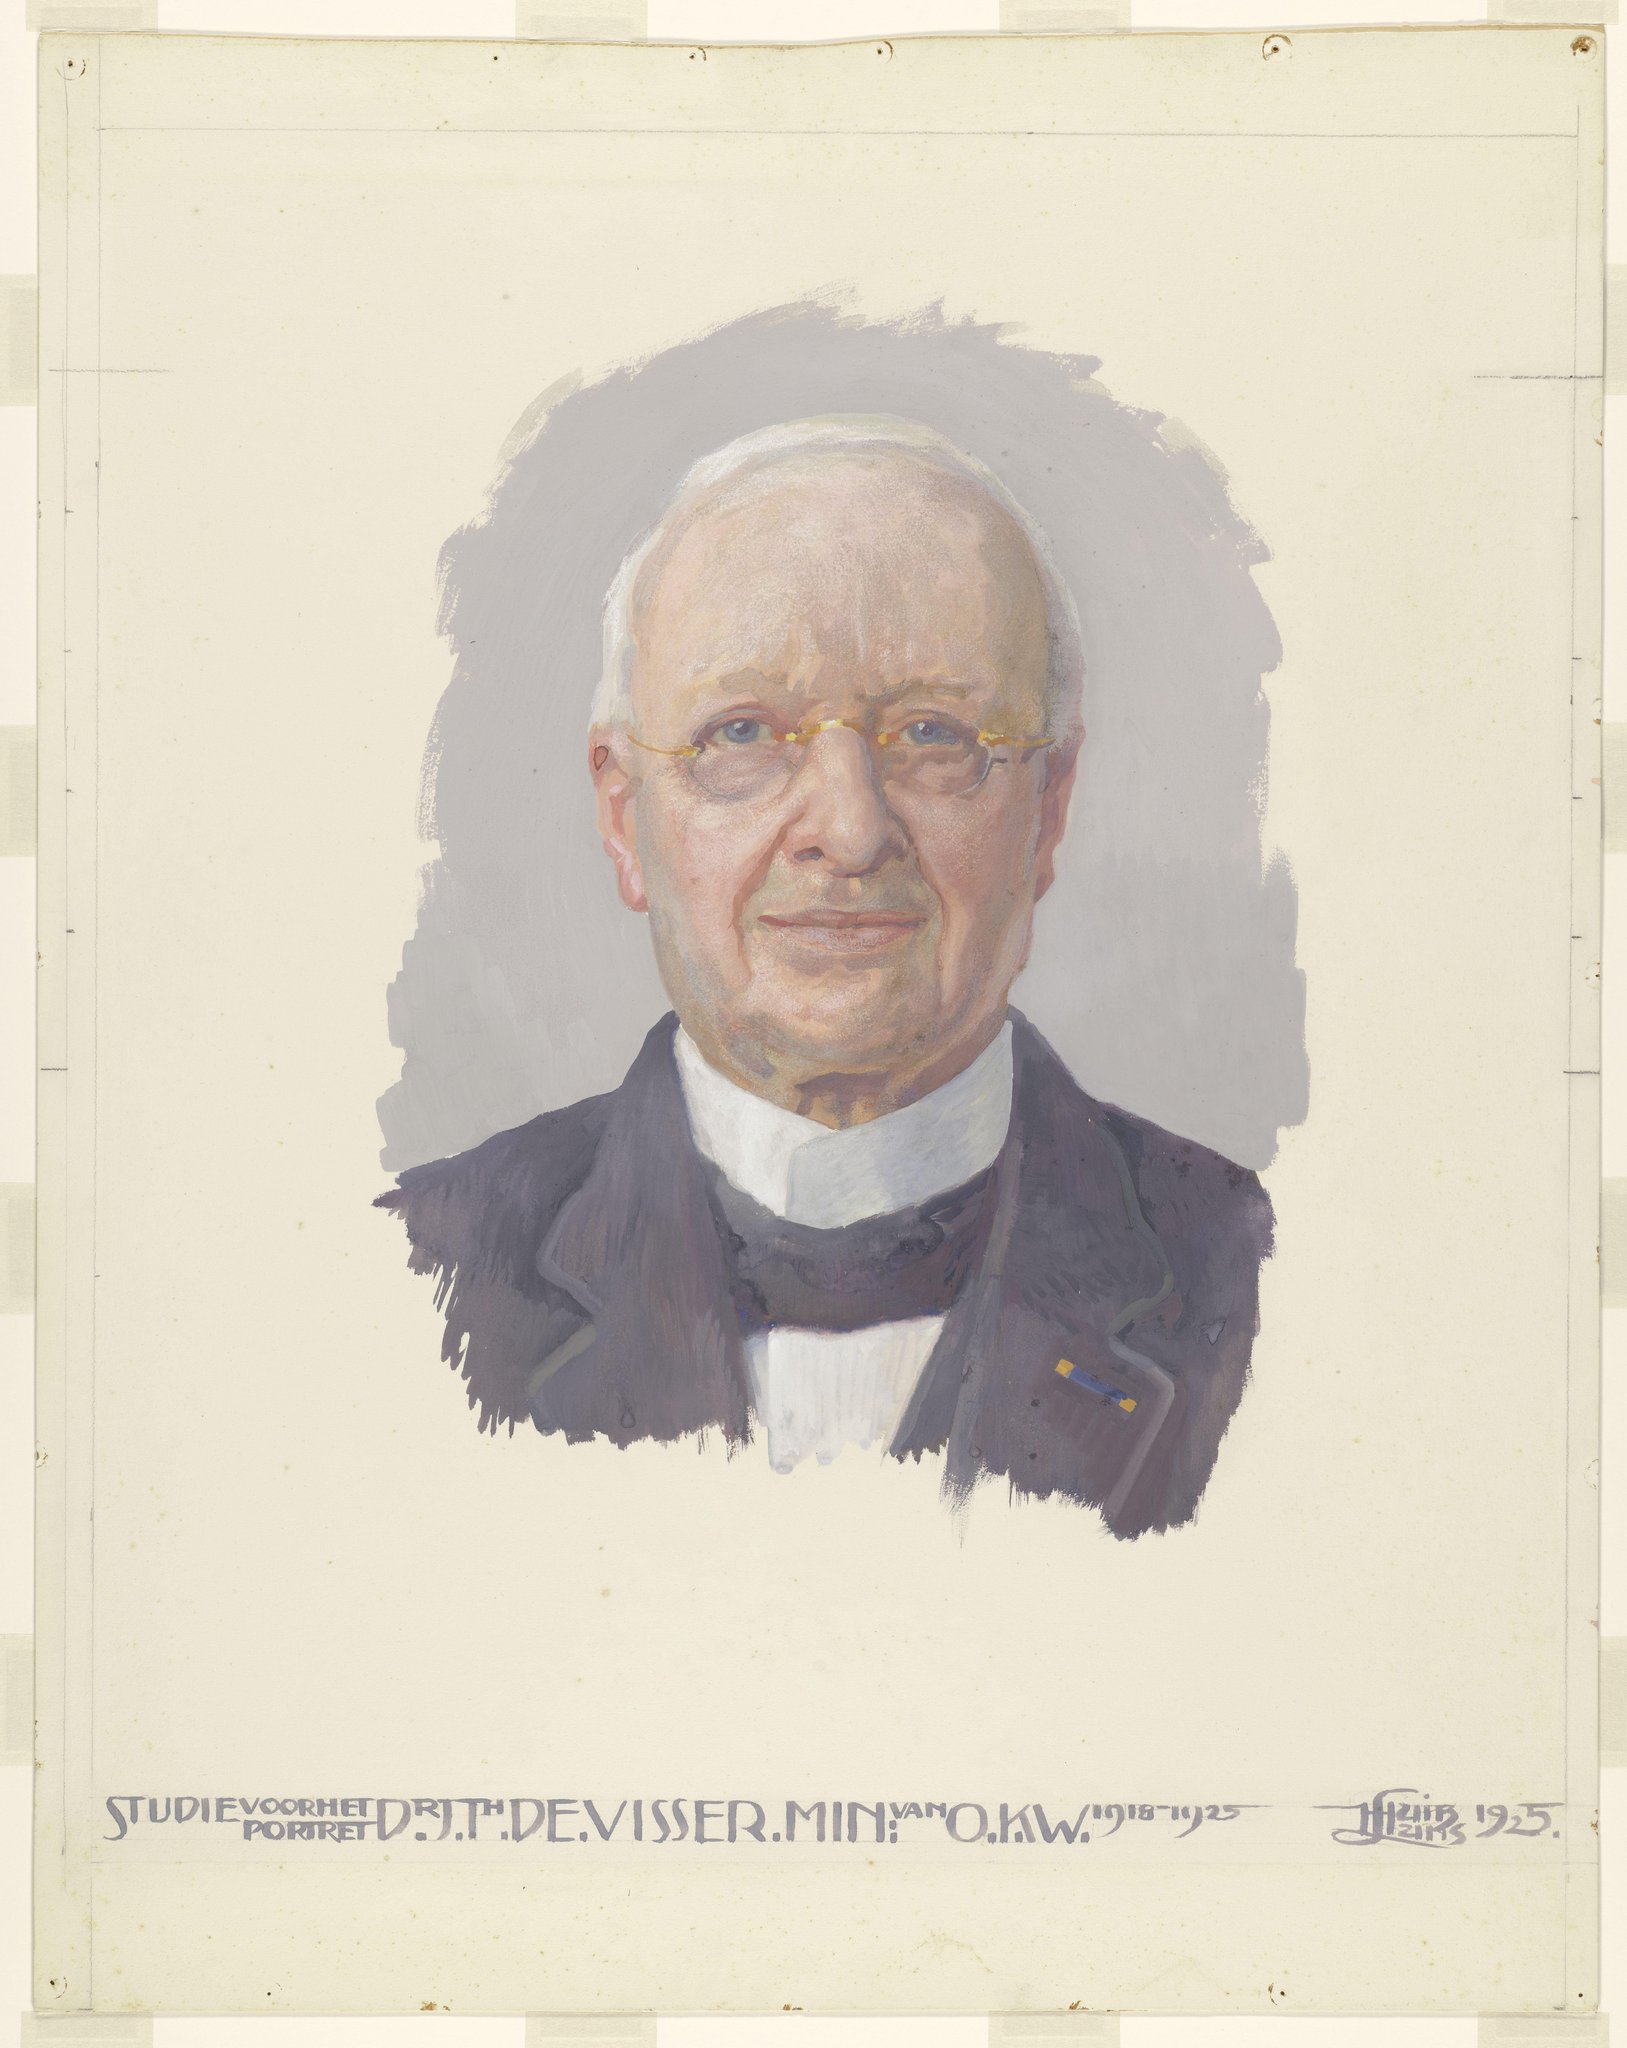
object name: drawing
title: Studie voor het portret van dr J.Th. de Visser, minister van O.K. en W. 1918-1925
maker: huib luns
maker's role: draughtsman, print maker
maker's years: 1881-1942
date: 1925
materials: cardboard, gouache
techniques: brush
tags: utrecht, the hague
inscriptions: title: ‘Studie voor het portret van dr J.Th.de.Visser. min: van O.K. en W. 1918-1925’, signature and date: ‘Huib Luns 1925’, address: ‘Luns/ Valeriusstraat 49’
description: Schouderstuk van een man met grijs haar en een bril tegen een lichtgrijs fond.